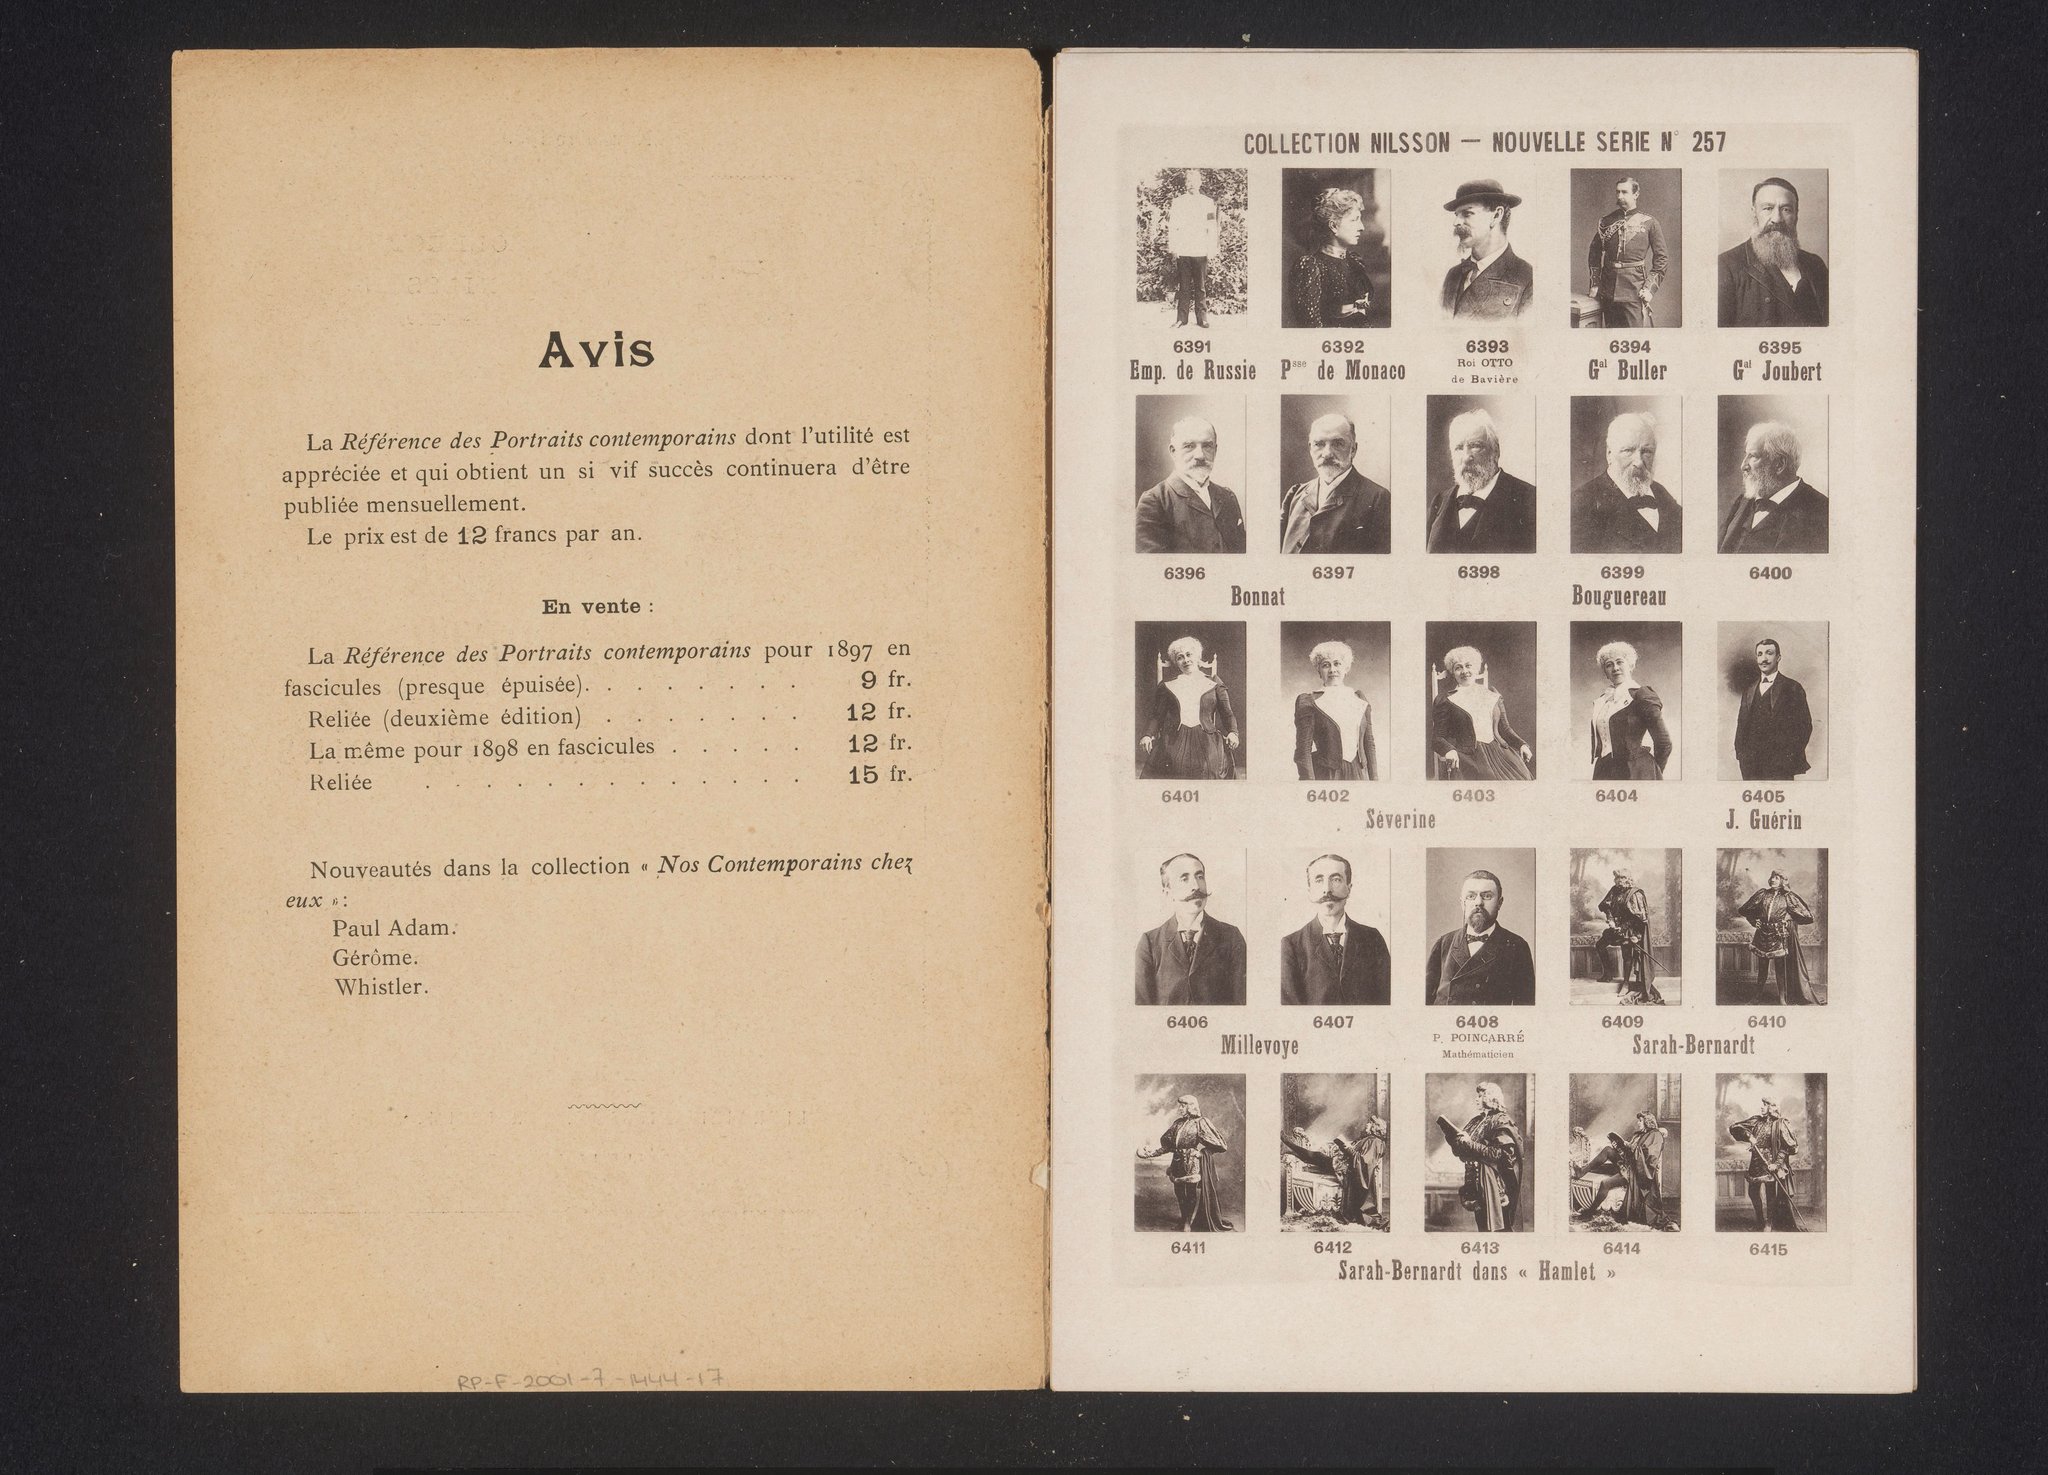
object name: photomechanical print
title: 25 portretten van Nicolaas II van Rusland, Otto I van Beieren, Sarah Bernhardt en anderen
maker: Anonymous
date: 1894-1899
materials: paper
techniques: photograph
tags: paris, sculptor, sarah bernhardt, historical persons - bb - woman, historical persons, portrait of actor, actress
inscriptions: number: ‘No 257’, inscription: ‘Emp. de Russie Psse de Monaco Roi OTTO/ de Bavière Gal Buller Gal Joubert/ Bonnat Bouguereau/ Séverine J. Guérin/ Millevoye P. POINCARRÉ/ Mathématicien Sarah-Bernardt/ Sarah-Bernardt dans < < Hamlet > >’